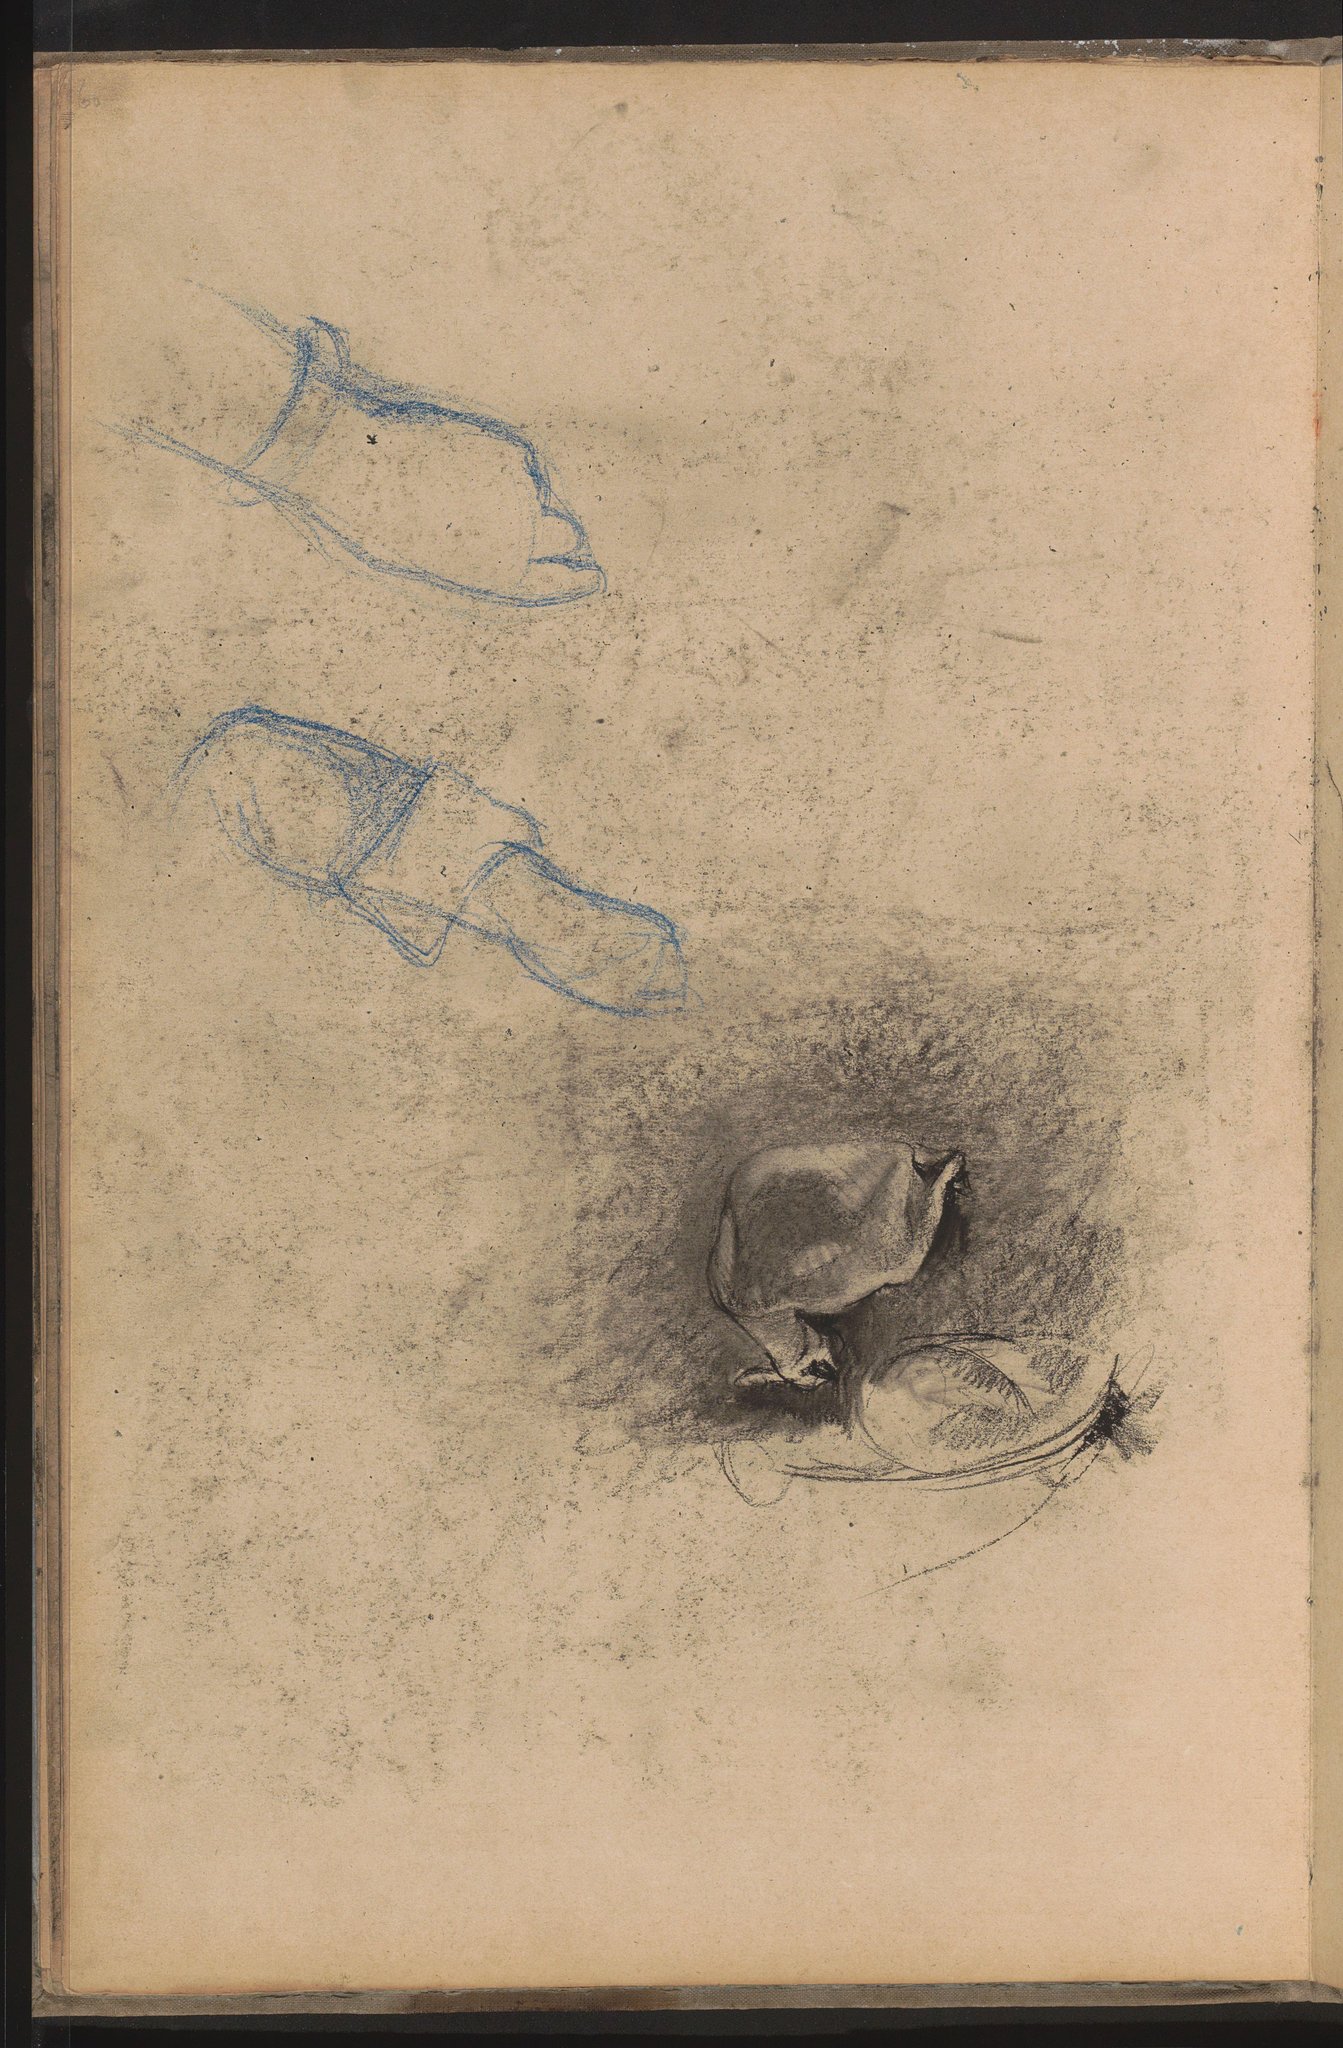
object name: sketchbook leaf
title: Studieblad met handen en schapen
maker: willem witsen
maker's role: draughtsman, painter, print maker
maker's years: 1860-1923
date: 1884-1887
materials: chalk, paper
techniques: stumping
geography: ewijkshoeve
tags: lower arm, hand, sheep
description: Pagina 60 uit een schetsboek met 45 bladen vervaardigd rond de Ewijkshoeve.